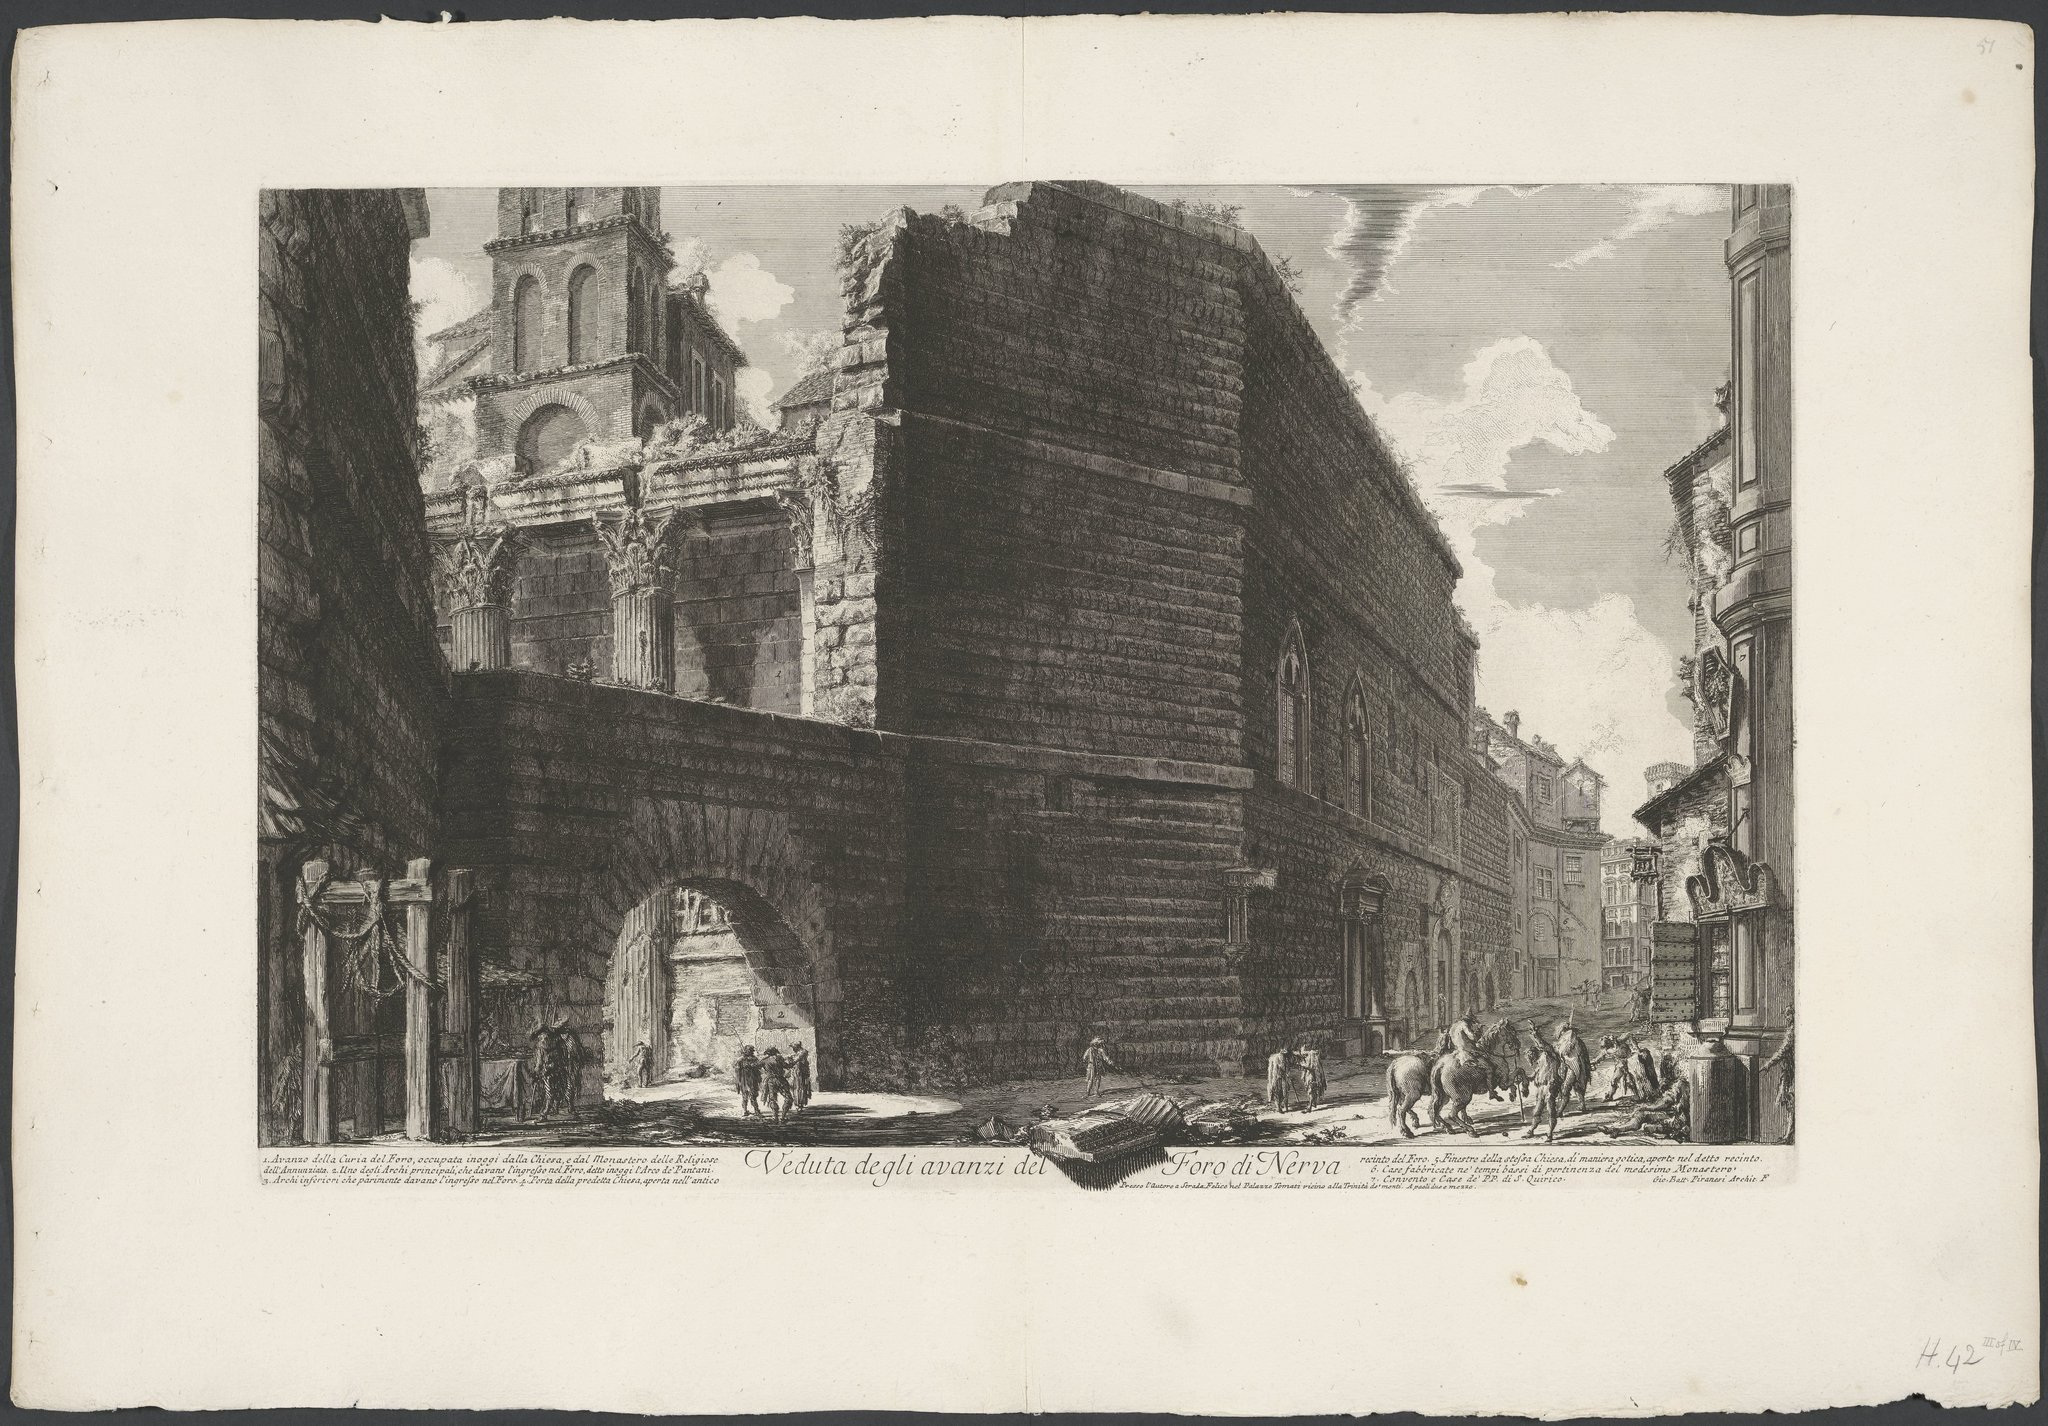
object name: print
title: Veduta degli avanzi del Foro di Nerva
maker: giovanni battista piranesi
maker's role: designer, draughtsman, print maker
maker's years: 1720-1778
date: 1748-1778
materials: paper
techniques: etching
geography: rome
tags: ruin of a building ~ architecture, landscape with ruins, rome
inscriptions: collector's mark: Lugt 2228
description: Deze prent maakt deel uit van de serie 'Vedute di Roma'. Piranesi werkte aan deze 135 platen tellende serie tussen 1748 en zijn dood in 1778. Francesco Piranesi voegde later nog twee prenten toe aan de reeks van zijn vader.